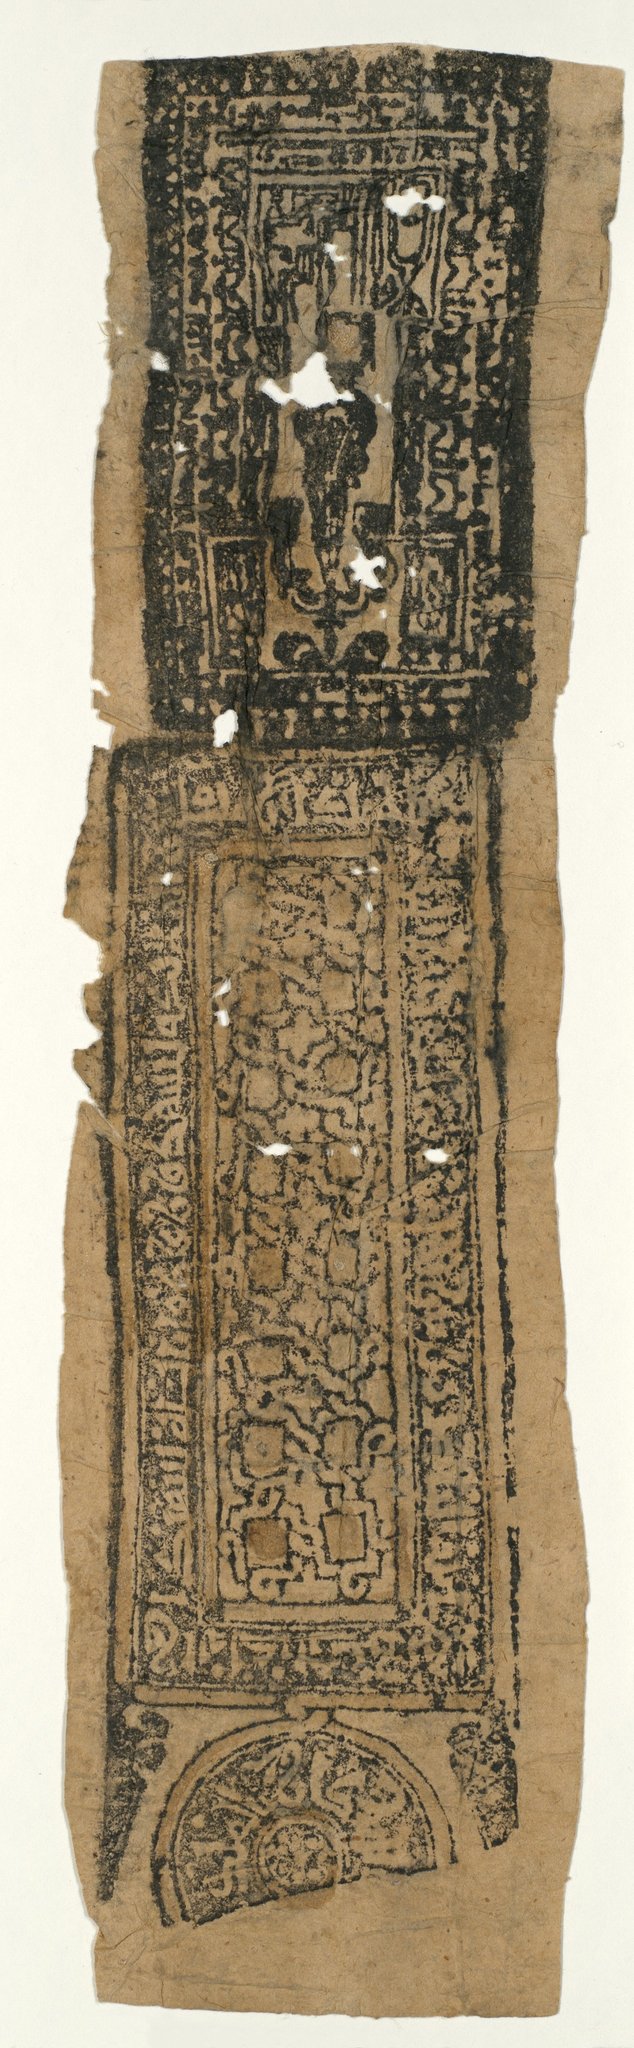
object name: scroll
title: Talismanic Scroll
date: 1001-1200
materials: ink, paper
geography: egypt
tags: scrolls